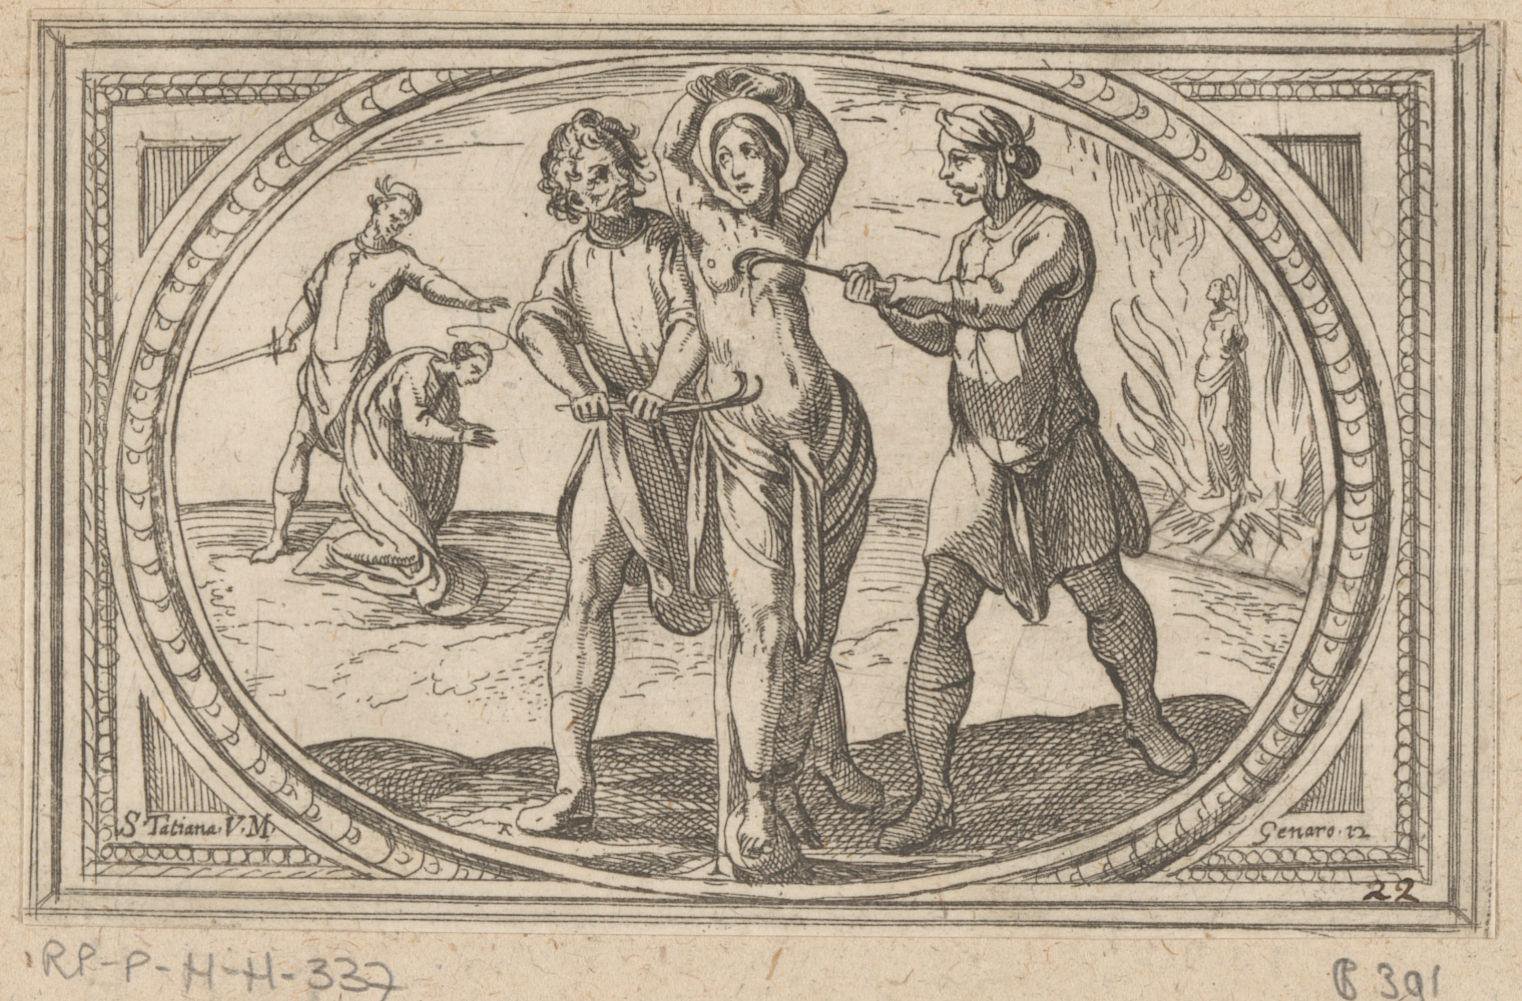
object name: print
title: Imagini di moltes vergini Rom nel martirio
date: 1565-1630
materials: paper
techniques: etching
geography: rome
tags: martyr(s) (often with palm-branches) - qq - female martyr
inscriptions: number: ‘22’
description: Deze prent maakt deel uit van een reeks van 73 prenten (+ titelprent) met voorstellingen van Romeinse martelaressen.